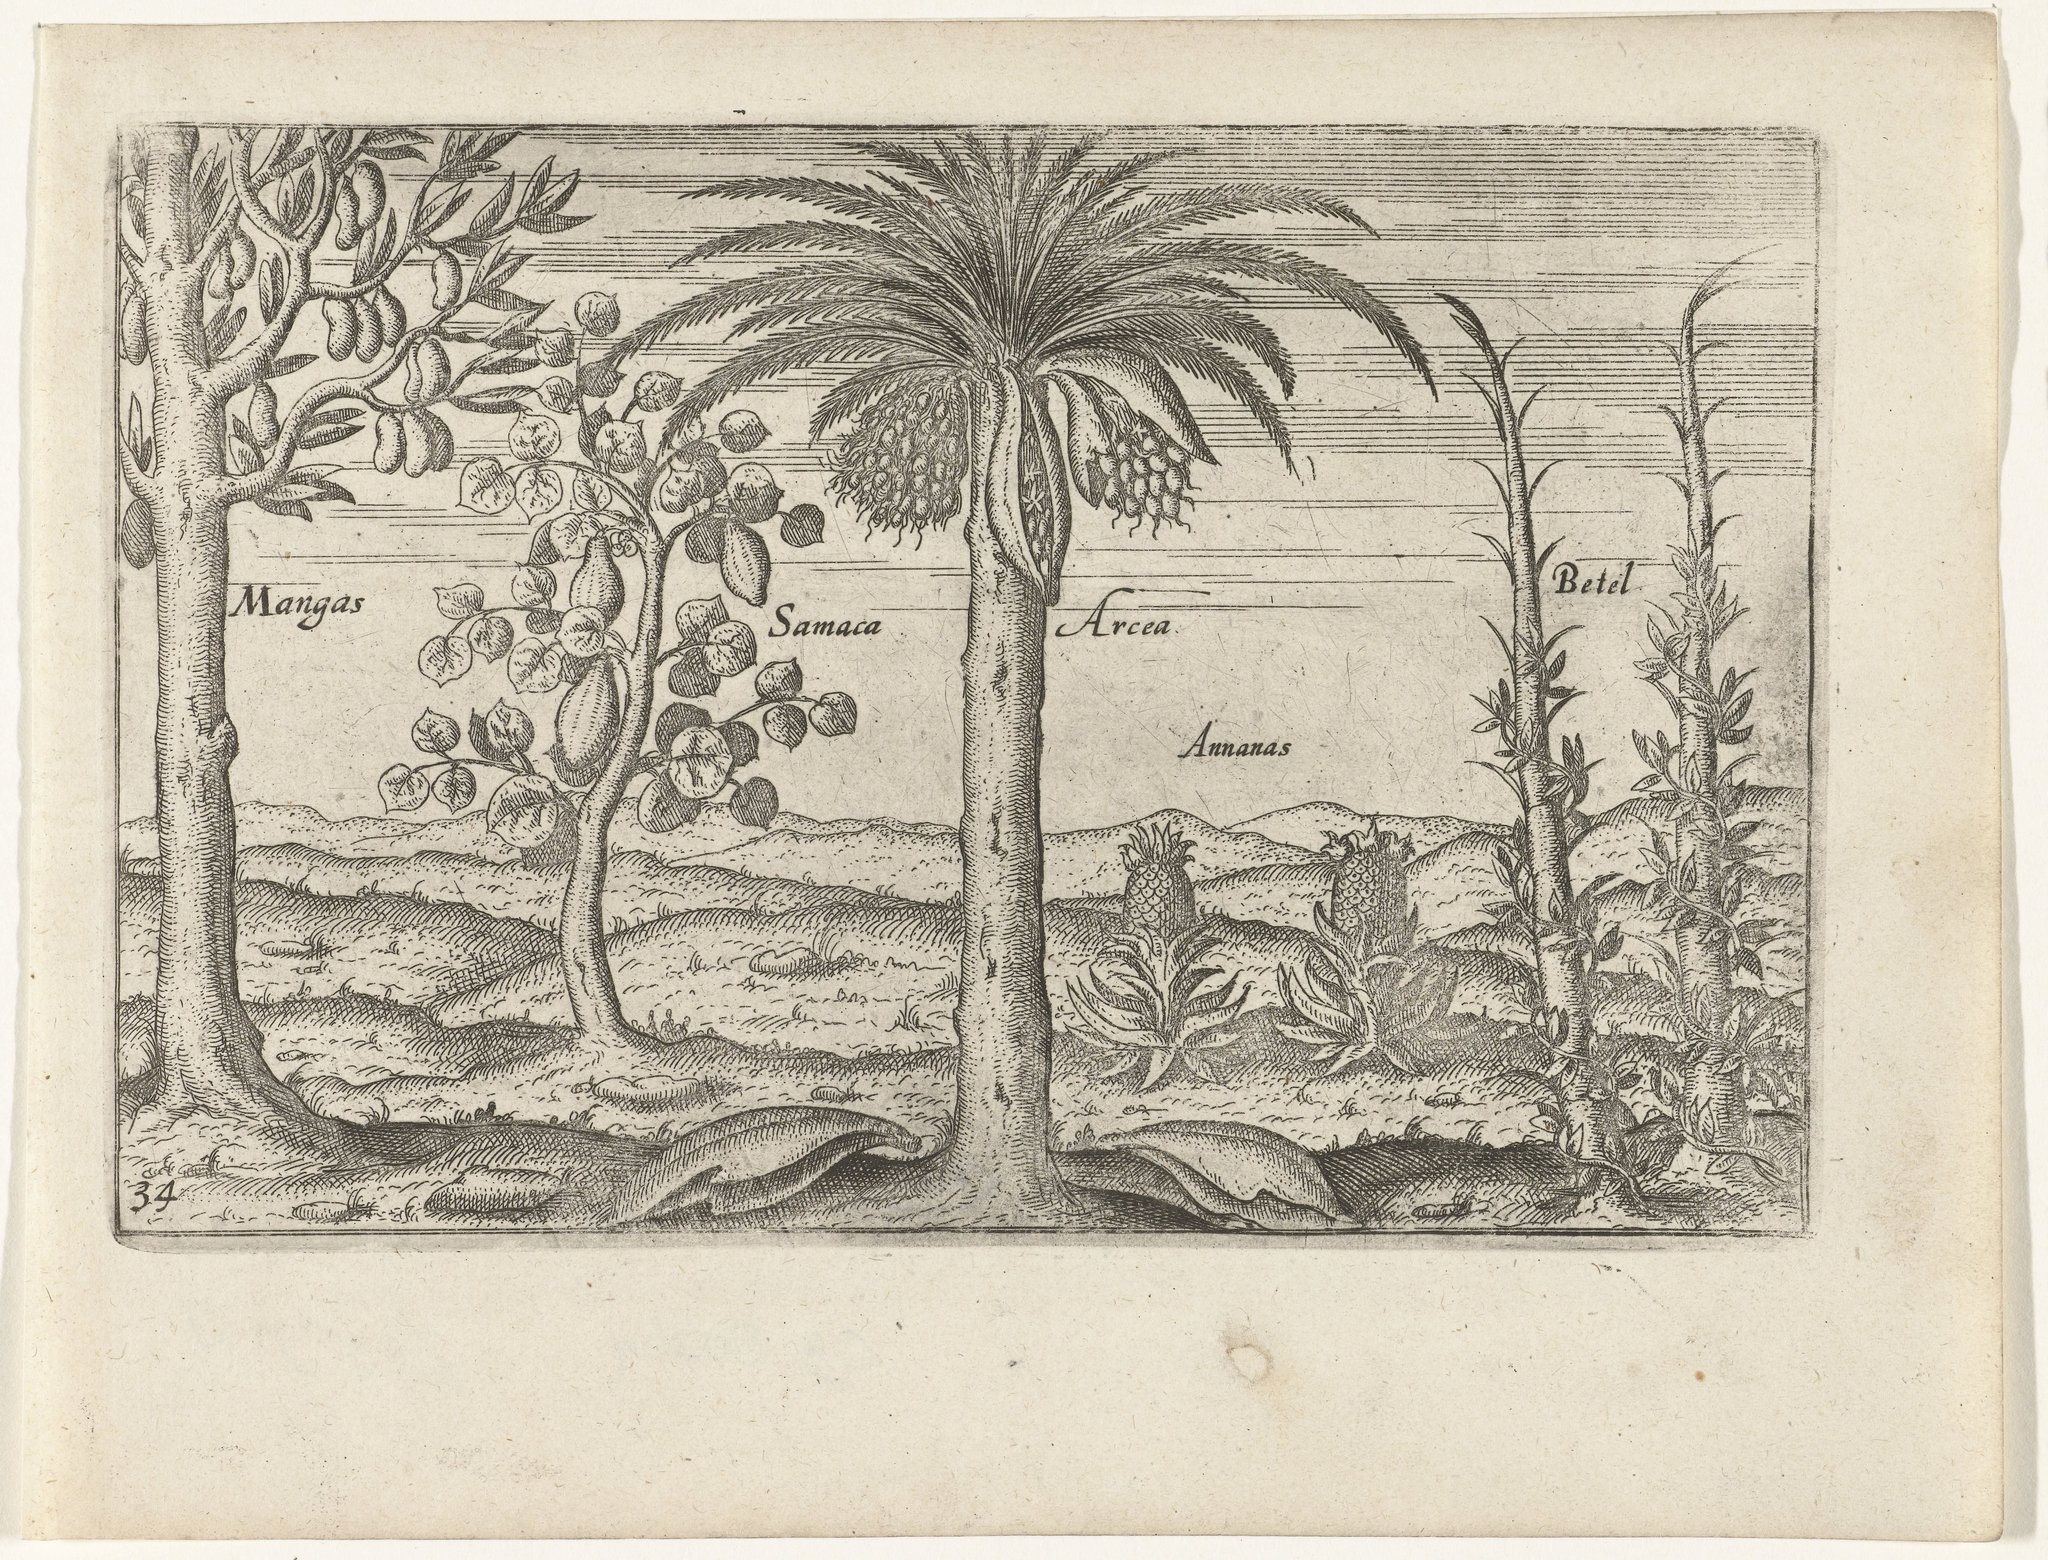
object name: print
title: Fruitbomen en kruiden op Java, 1596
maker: Anonymous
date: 1597-1598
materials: paper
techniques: engraving, etching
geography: northern netherlands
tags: gouda, plants; vegetation, landscapes in tropical and sub-tropical regions, exploration, expedition, voyage of discovery, java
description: Gebruikt als illustratie eerst in: Willem Lodewijcksz, D'eerste boeck. Historie van Indien, waer inne verhaelt is de avontueren die de Hollandtsche schepen bejeghent zijn, Cornelis Claes, Amsterdam 1598. In deze opgewerkte staat gebruikt in: De Eerste Schipvaerd der Hollandsche Natie naer Oost-Indien, waer inne verhaelt wordt al wat haer sonderlings onder wegen bejegent is ... ghetrocken uyt verscheyden Iournalen ofte dagh-registers daer van ghemaeckt, zeer vermaeckelijck ende nut om lesen. Opgenomen in: I. Commelin, Begin ende voortgangh, van de Vereenighde Nederlantsche Geoctroyeerde Oost-Indische Compagnie, J. Janssonius, Amsterdam 1646. Genummerd: 34.